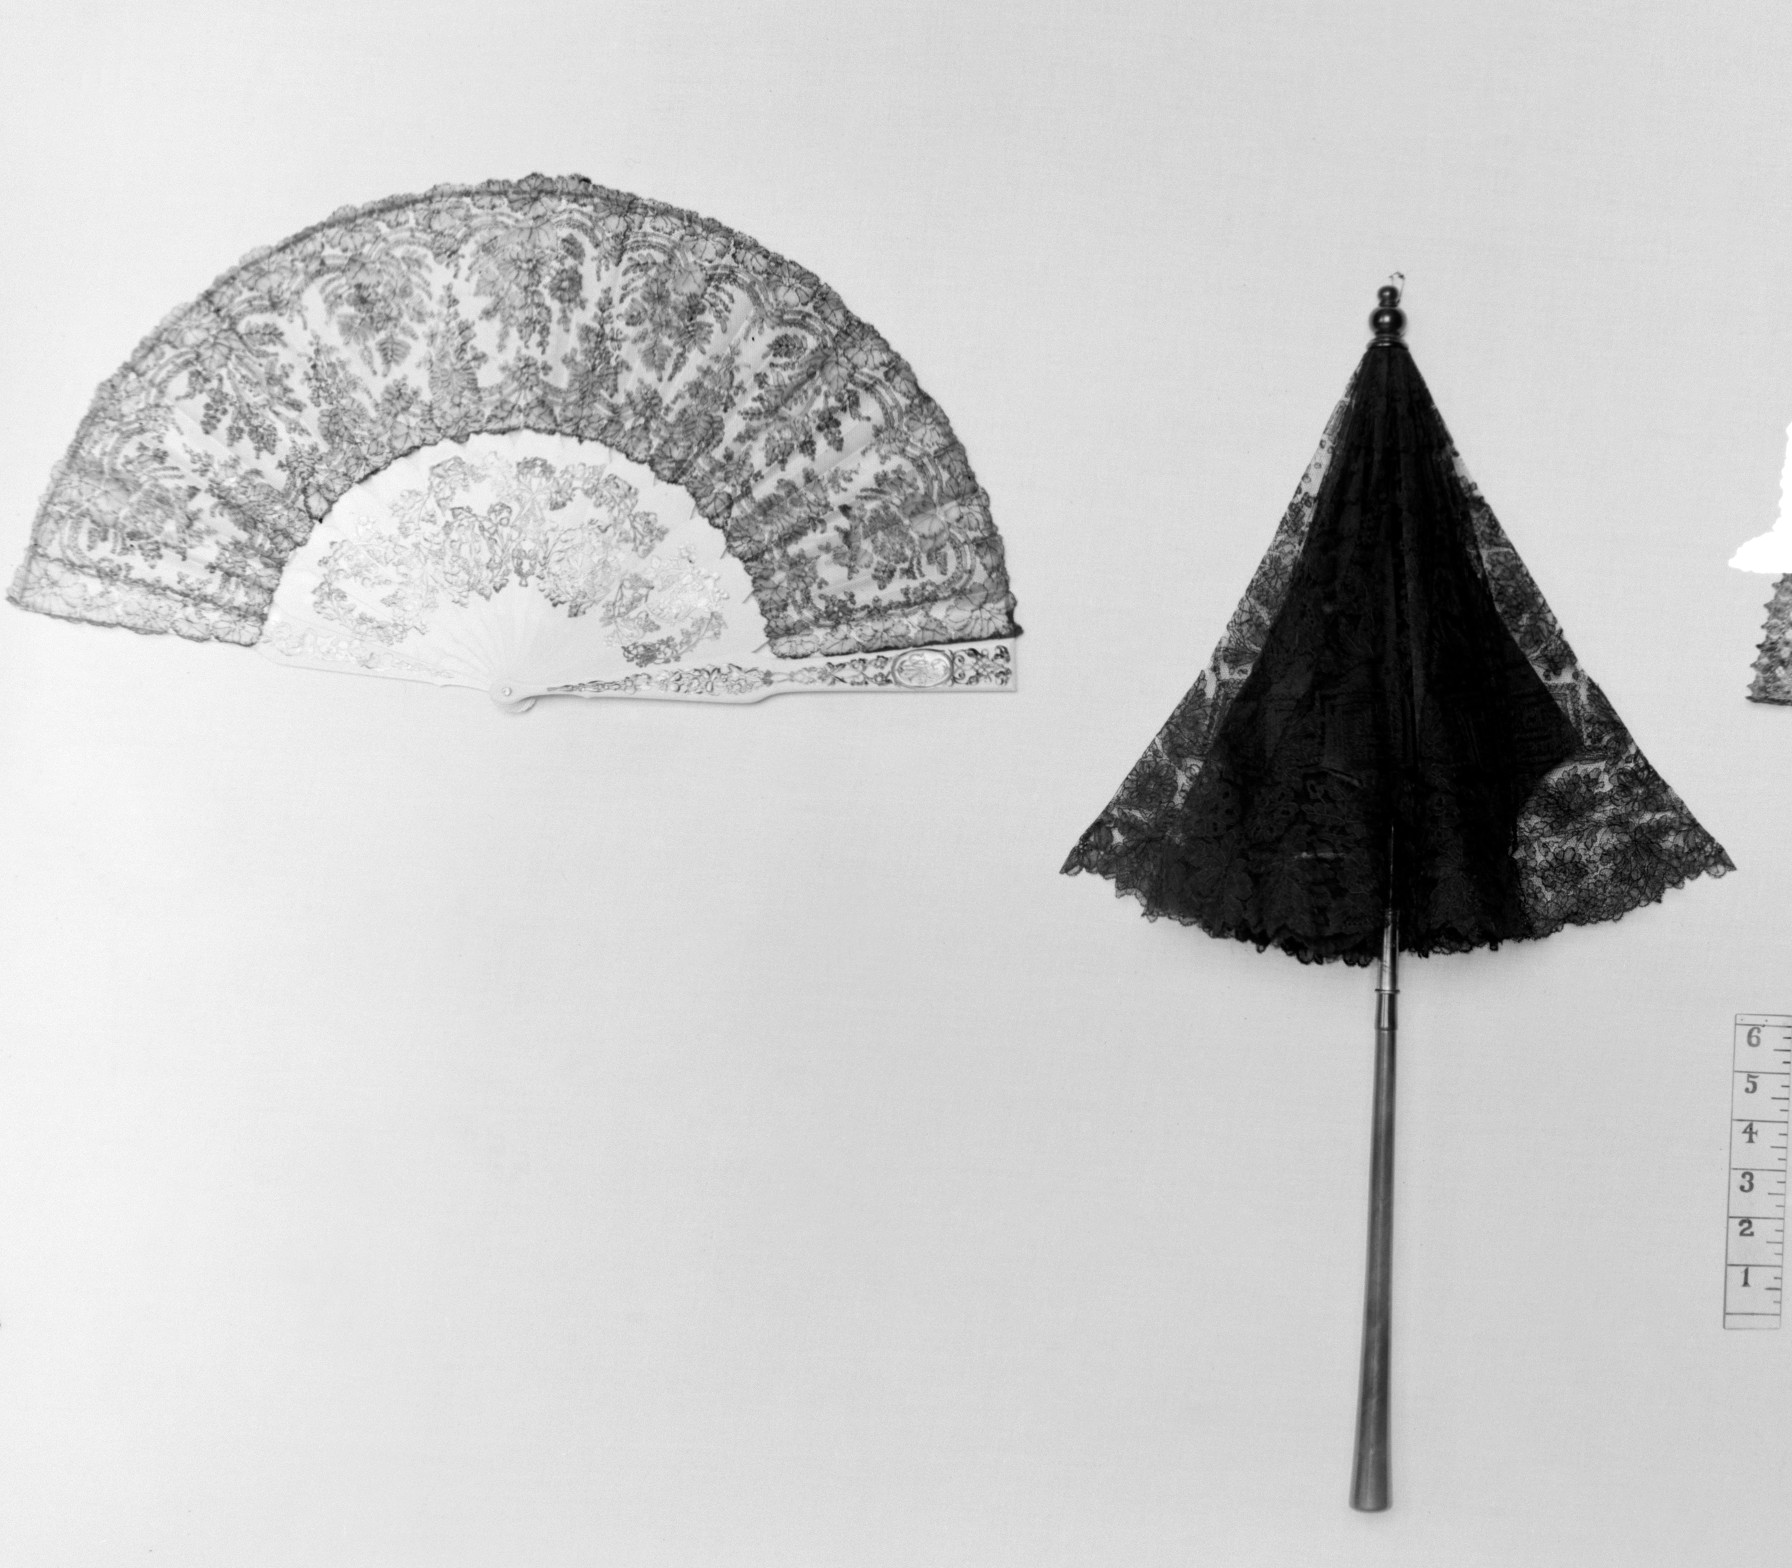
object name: fan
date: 1851-1900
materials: ivory, lace, mother of pearl, textile